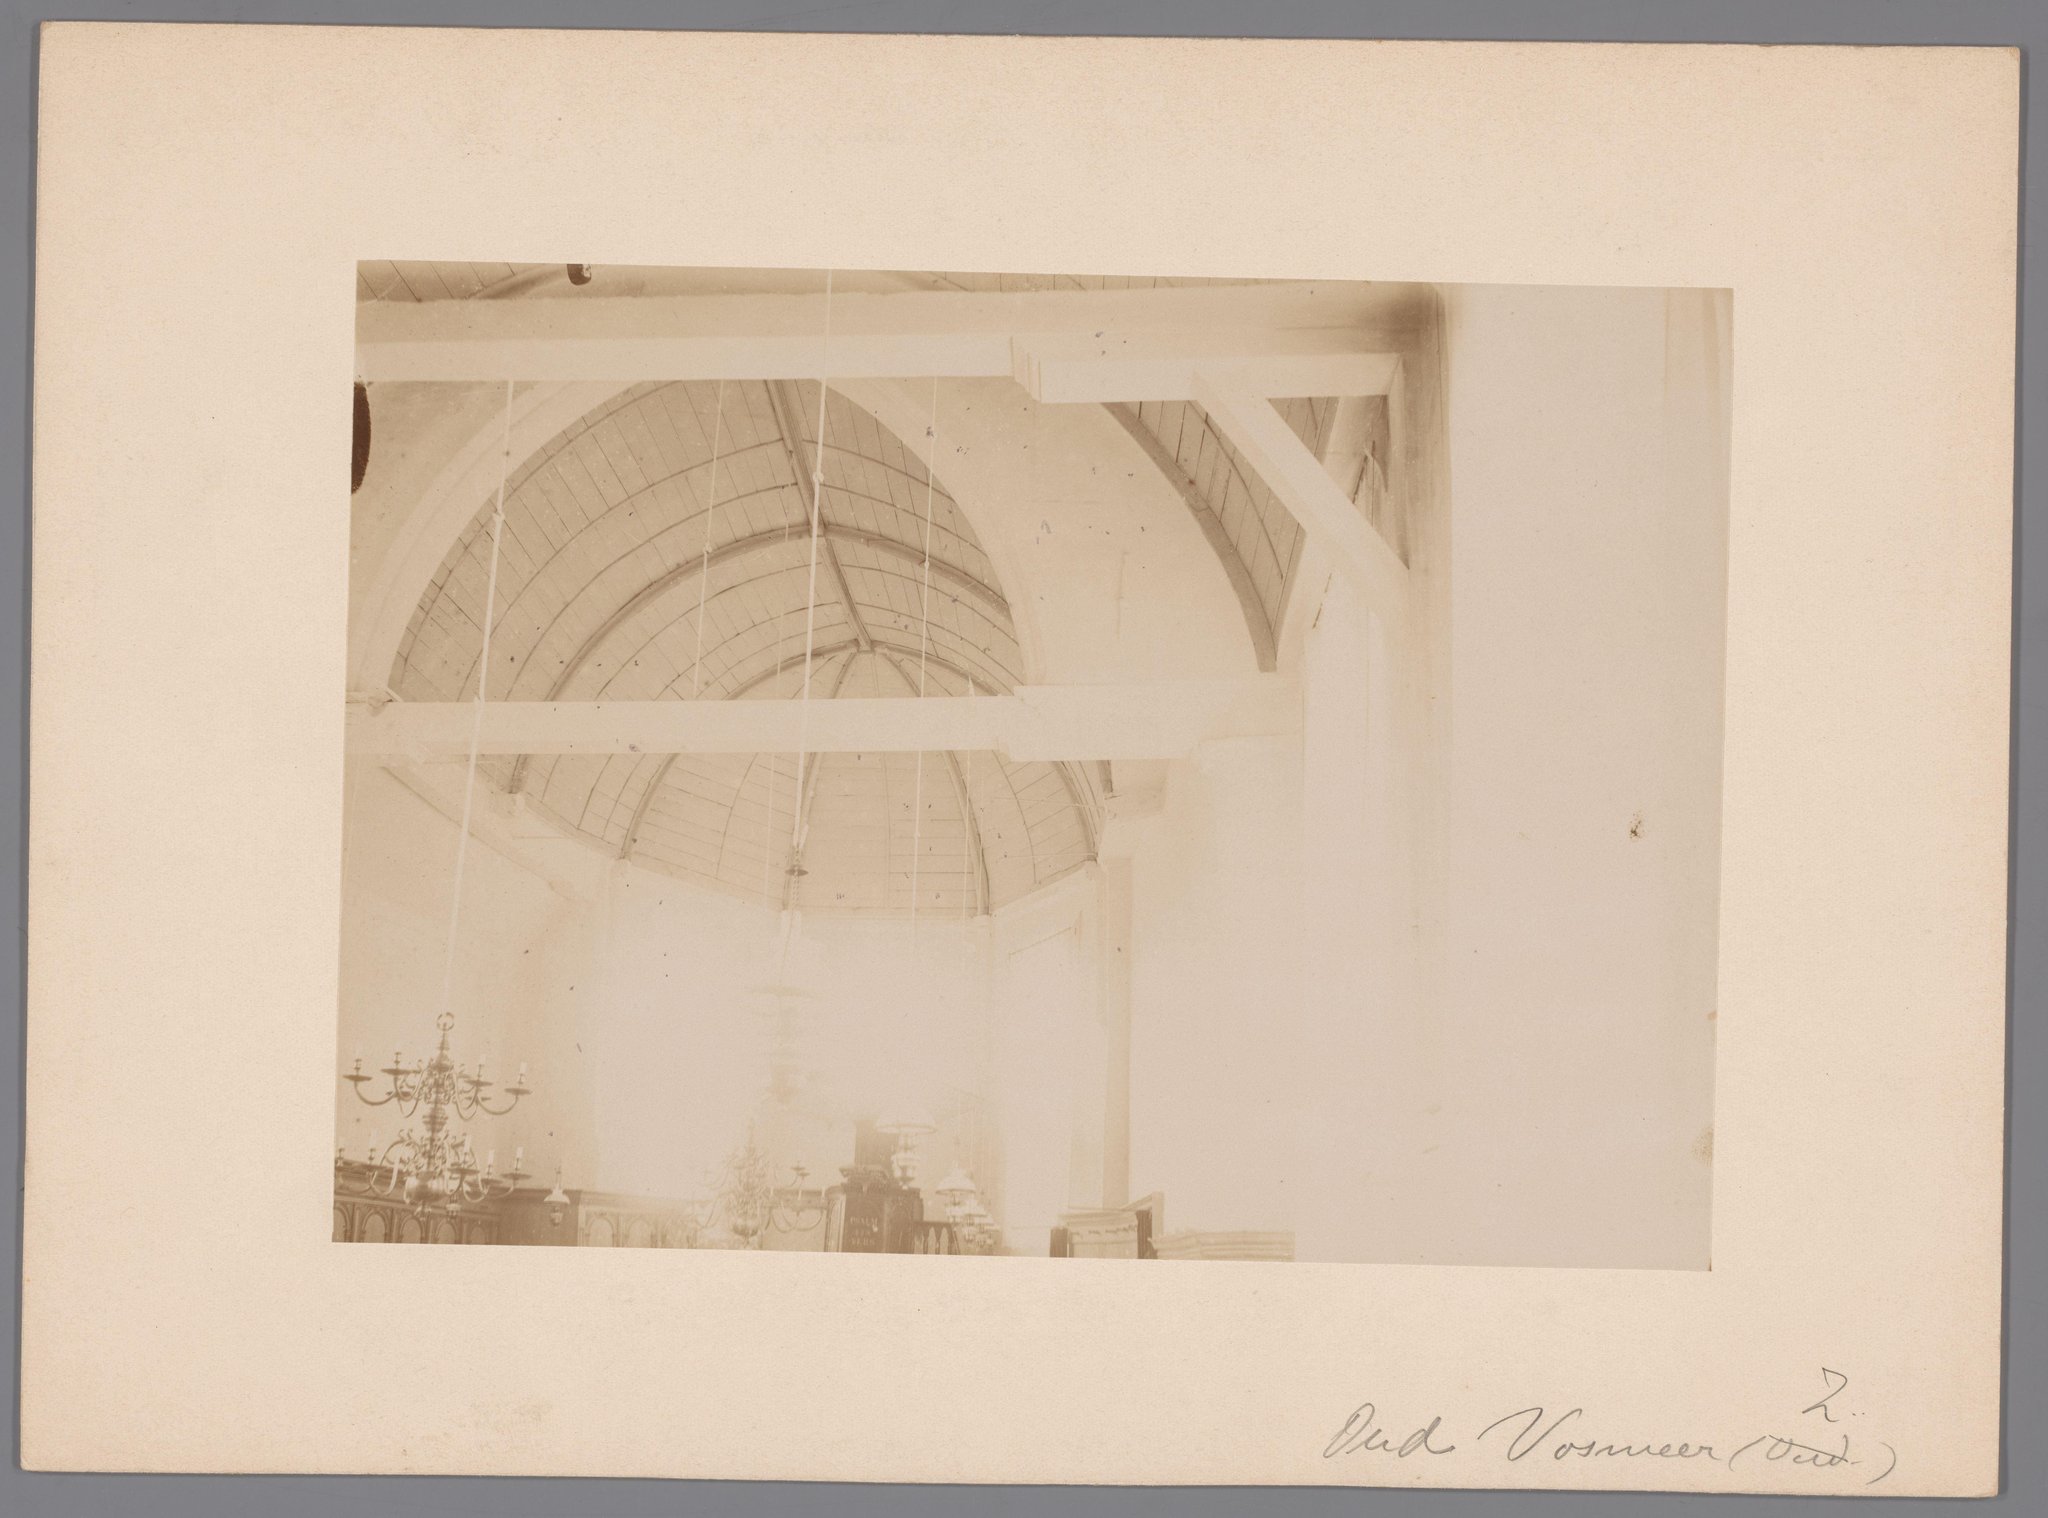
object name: photograph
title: Interieur van de Hervormde Kerk te Oud-Vossemeer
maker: anoniem (monumentenzorg)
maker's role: fotograaf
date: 1901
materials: cardboard, photographic support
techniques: albumen print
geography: oud-vossemeer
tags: interior of church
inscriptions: annotation: ‘Oud Vosmeer Zeeland N.H. Kerk/ sept 1901’, annotation: ‘Oud Vosmeer Z (Oud)’